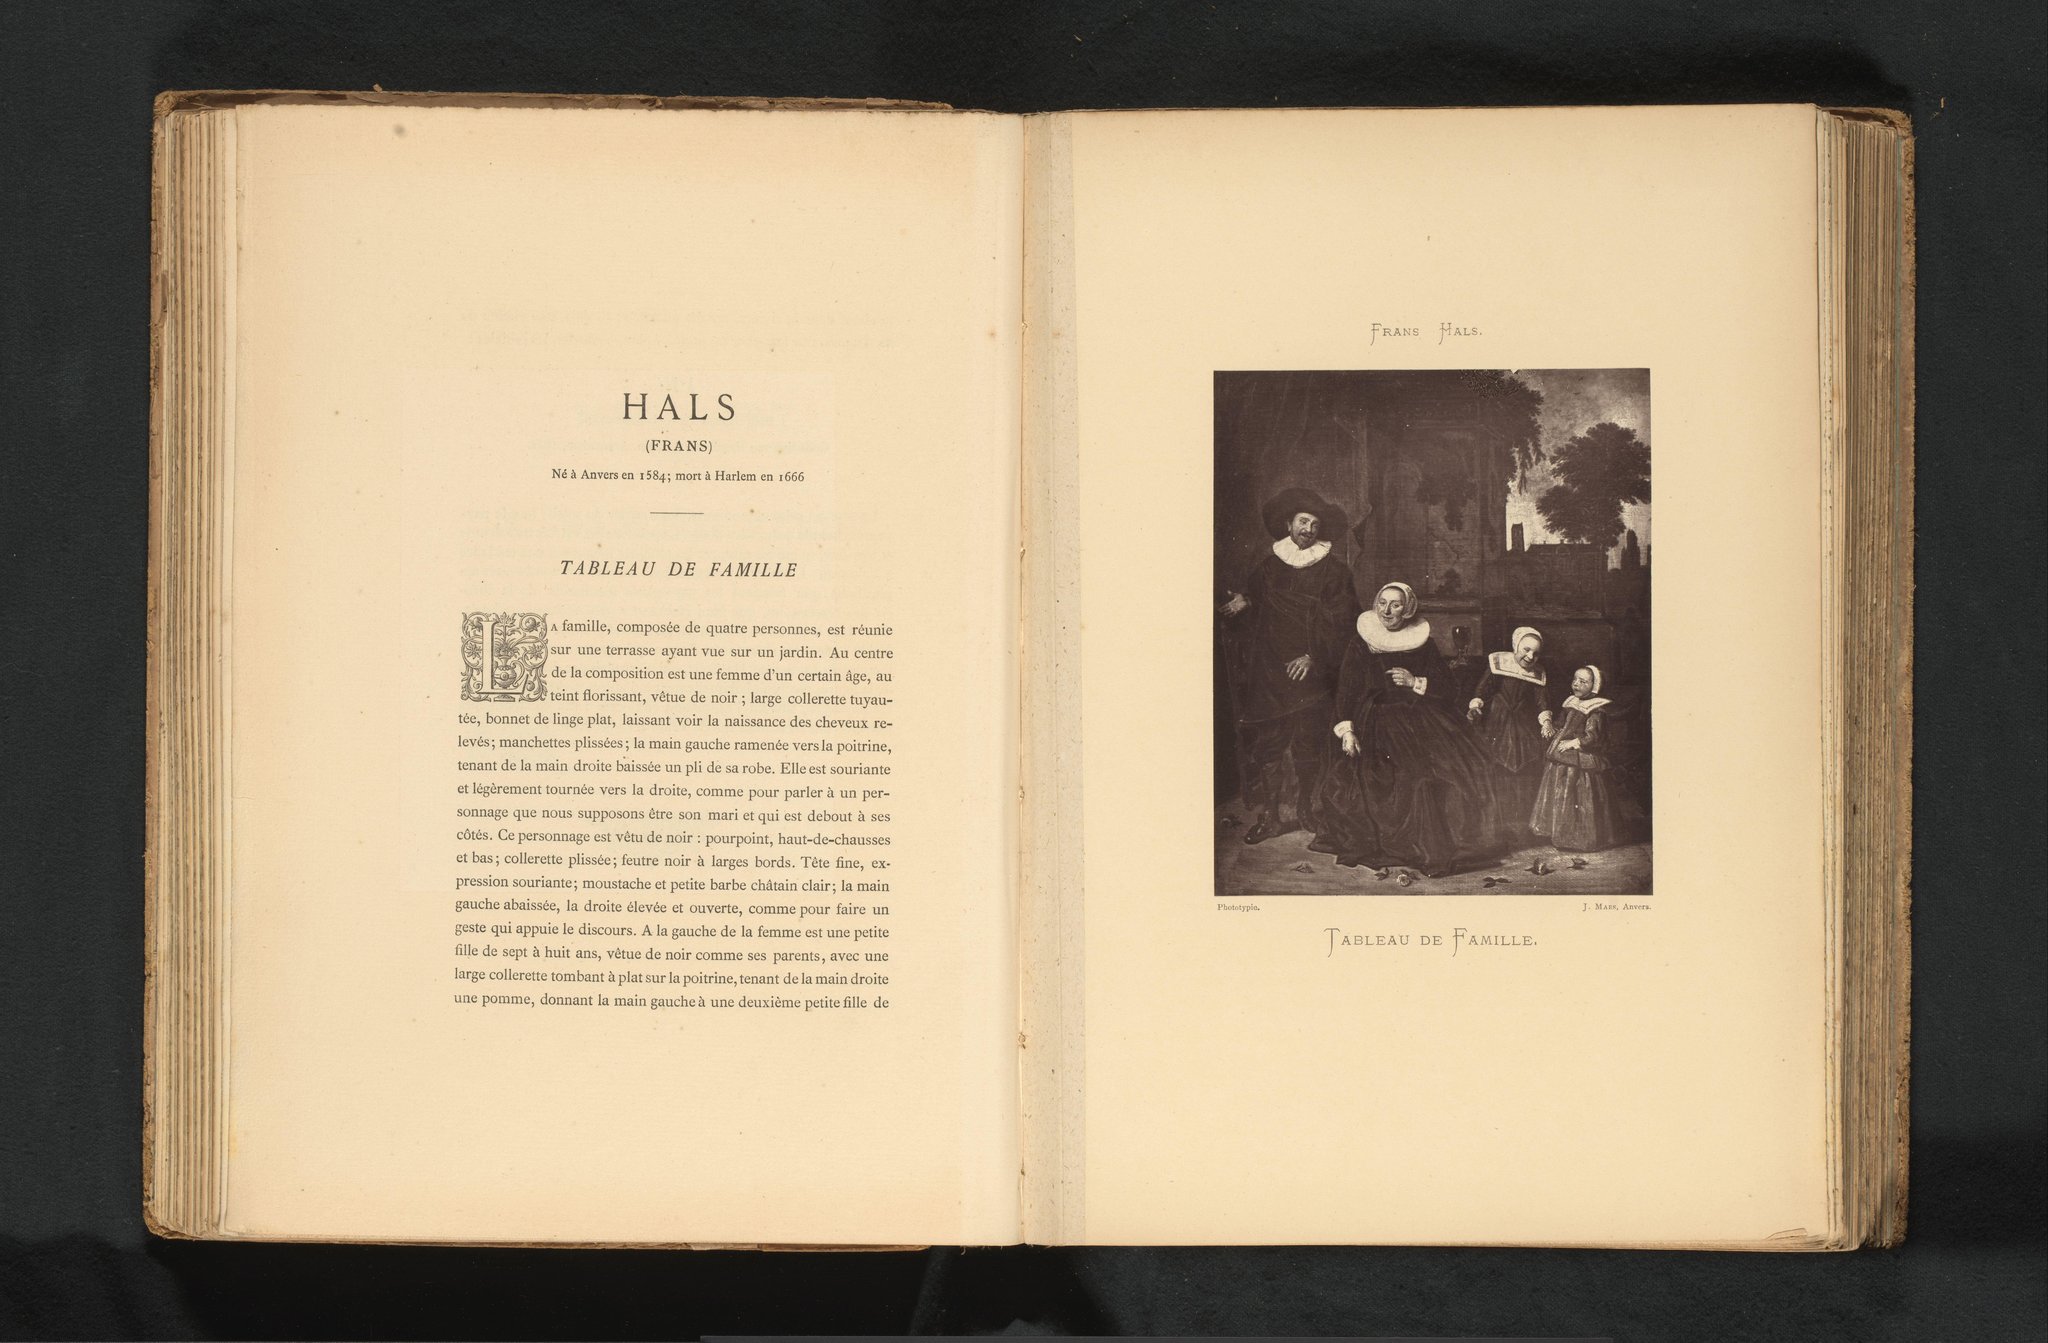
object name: page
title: Tableau de Famille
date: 1873-1878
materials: paper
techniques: woodburytype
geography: antwerp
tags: family life at home, anonymous historical persons portrayed in a group, in a group-portrait